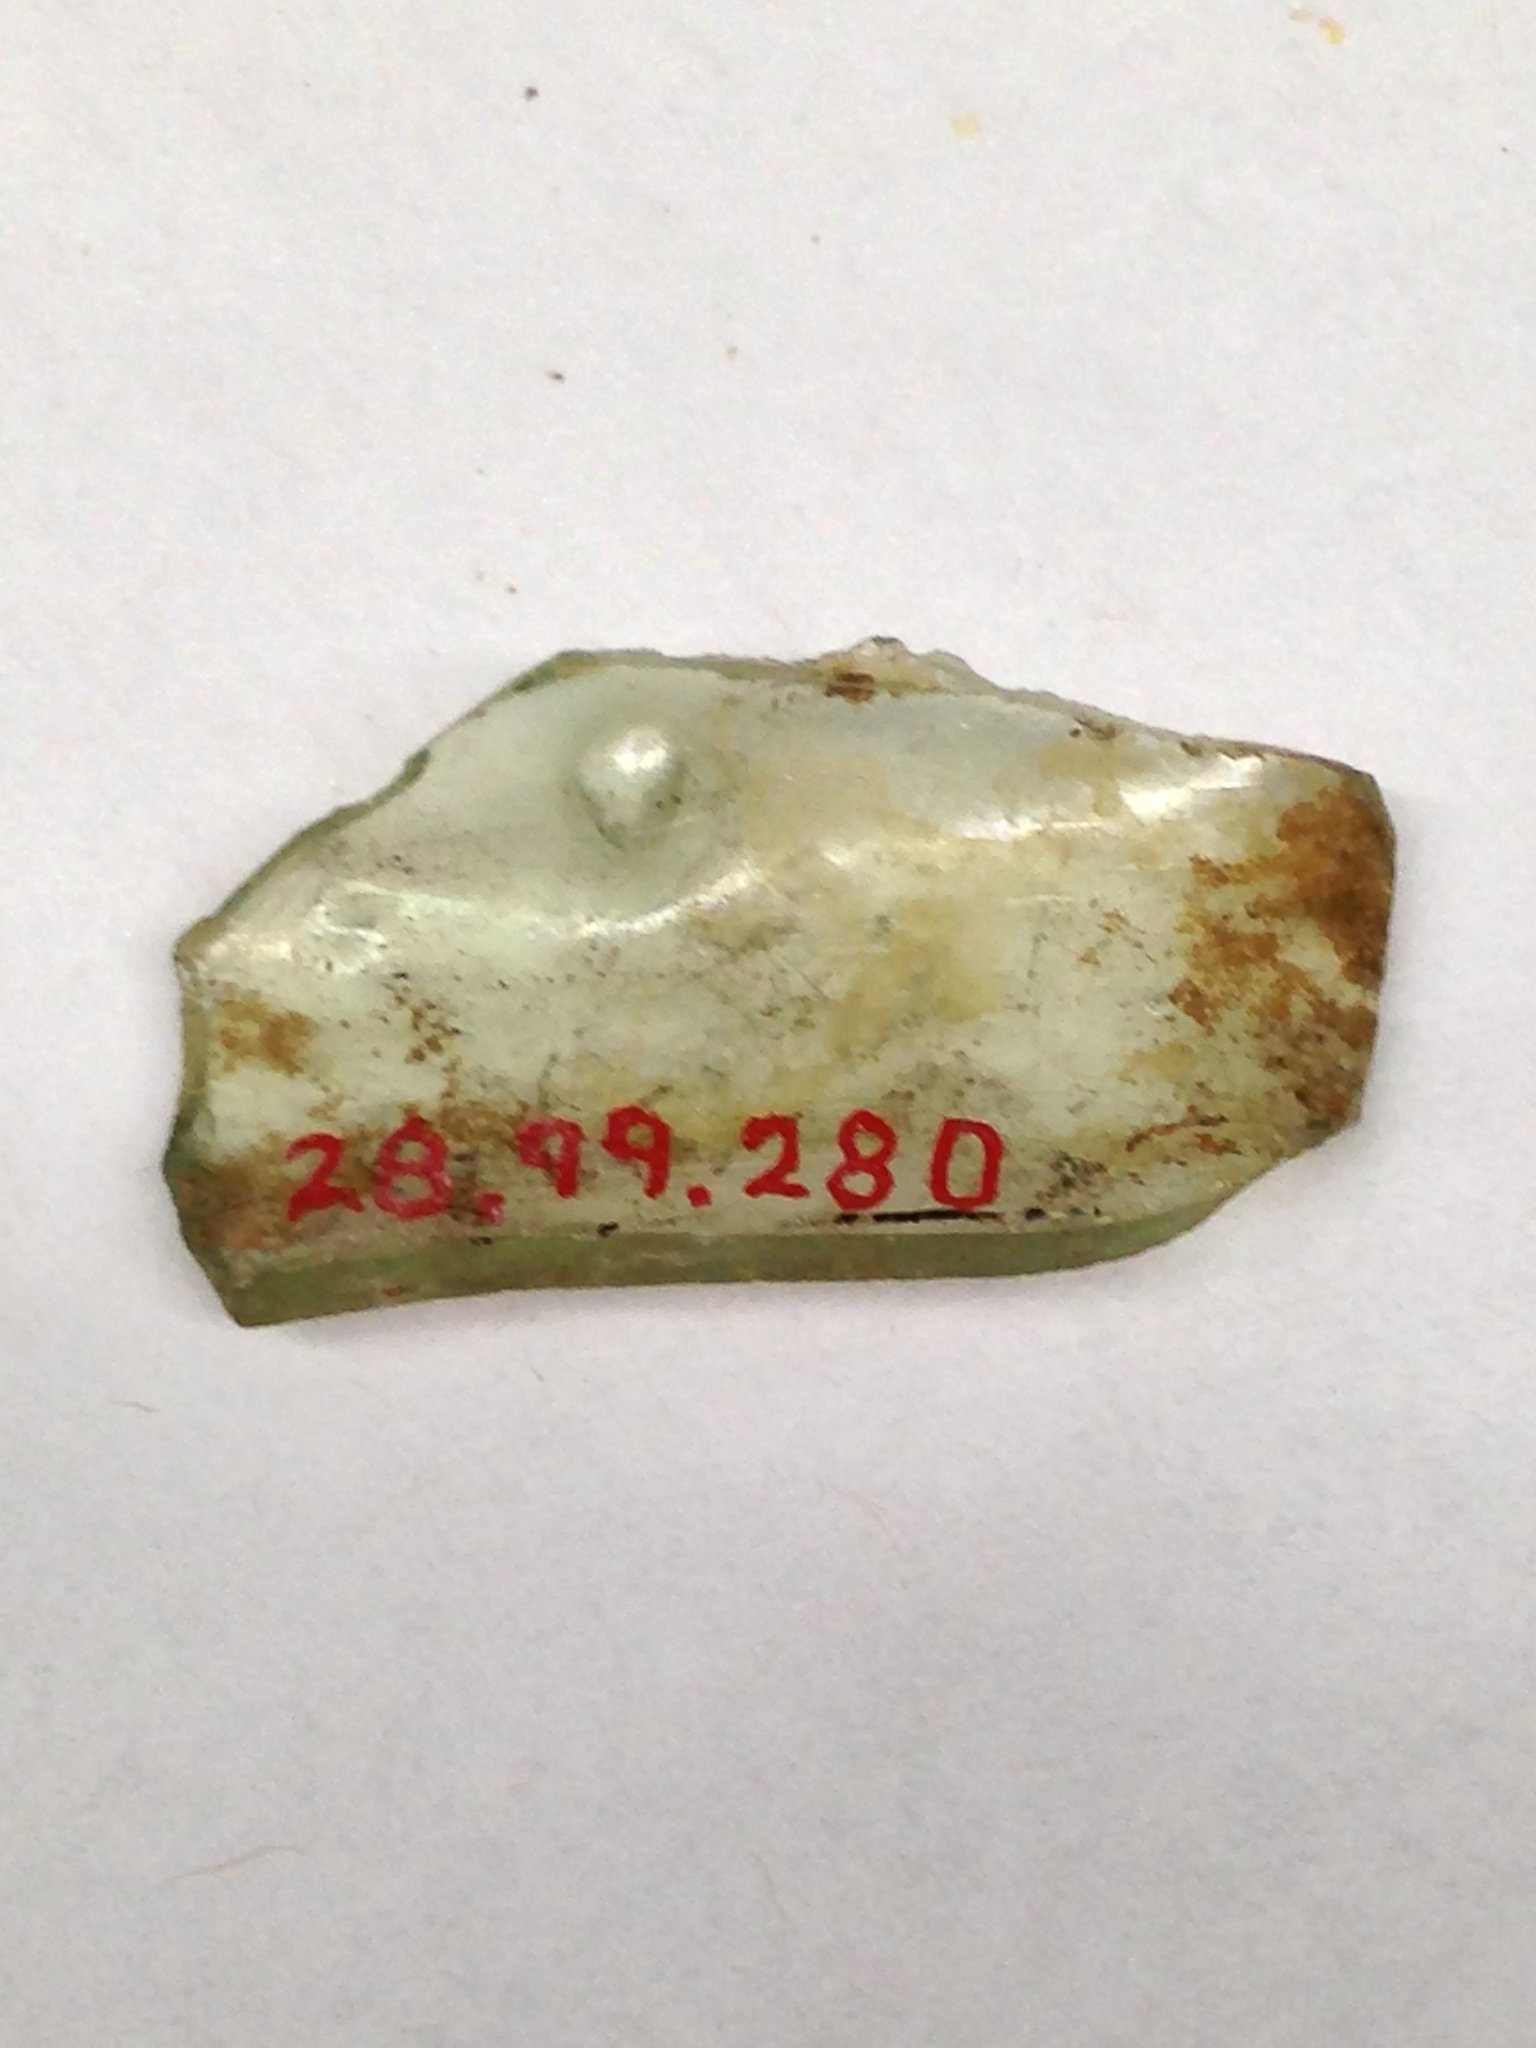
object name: fragment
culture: european or middle eastern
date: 1150-1250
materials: ceramic, glass